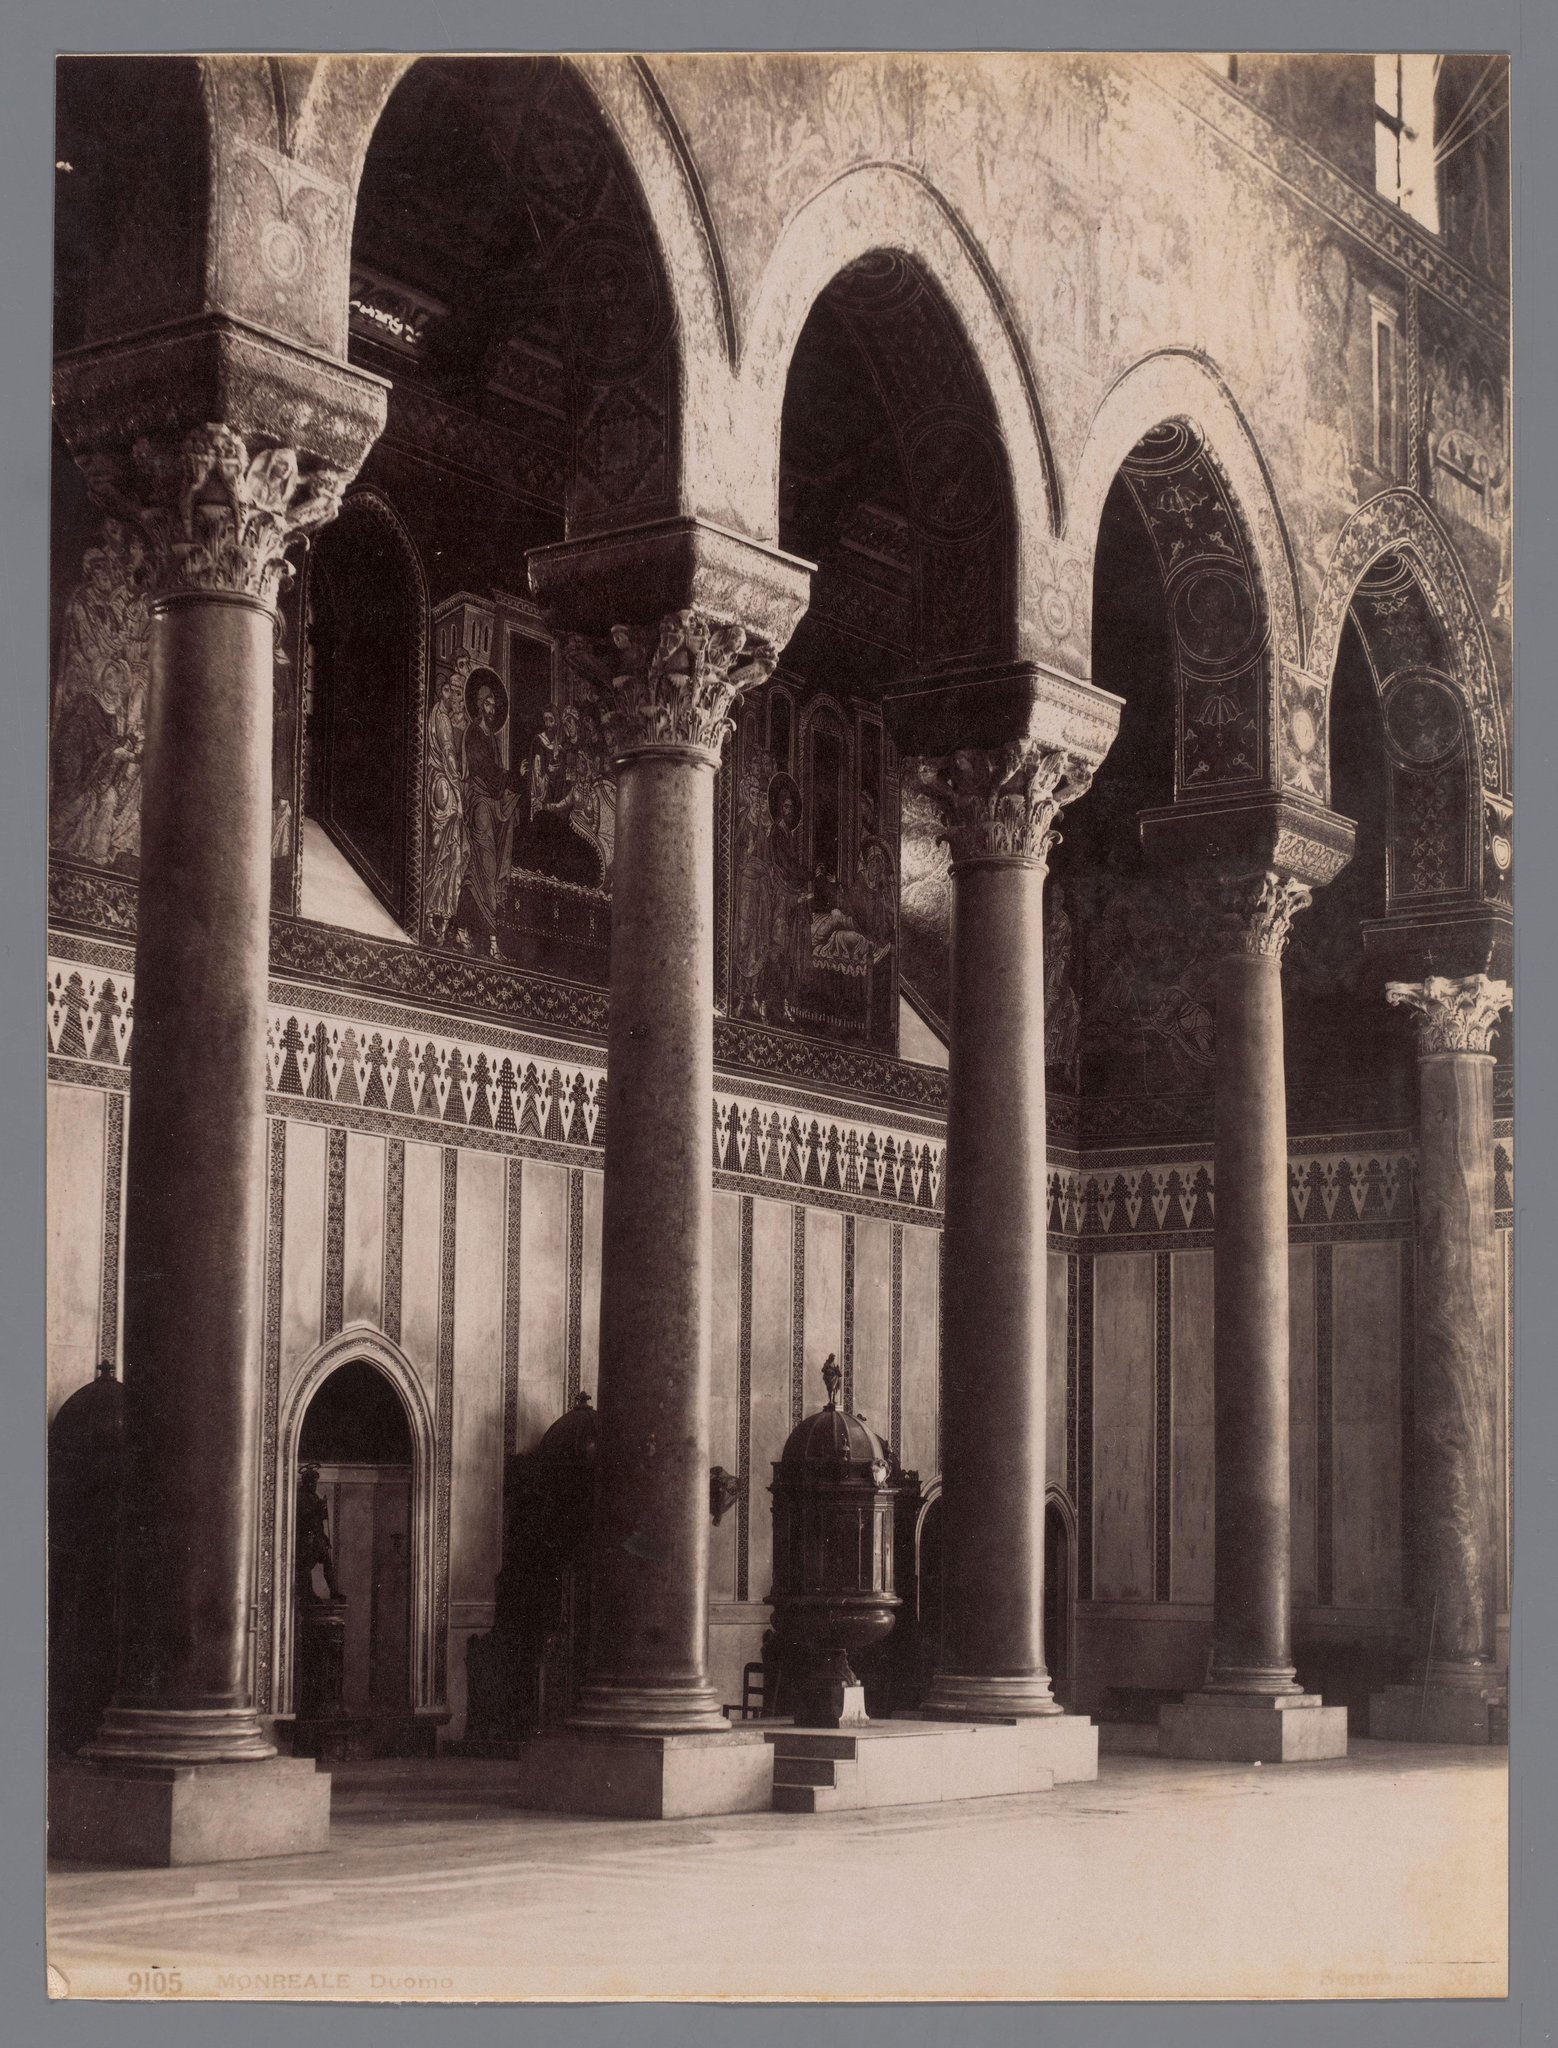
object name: photograph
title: Interieur van de kathedraal van Monreale, Sicilië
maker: giorgio sommer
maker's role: fotograaf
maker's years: 1834-1914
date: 1857-1914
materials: cardboard, paper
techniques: albumen print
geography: monreale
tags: interior of church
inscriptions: number: ‘9105’